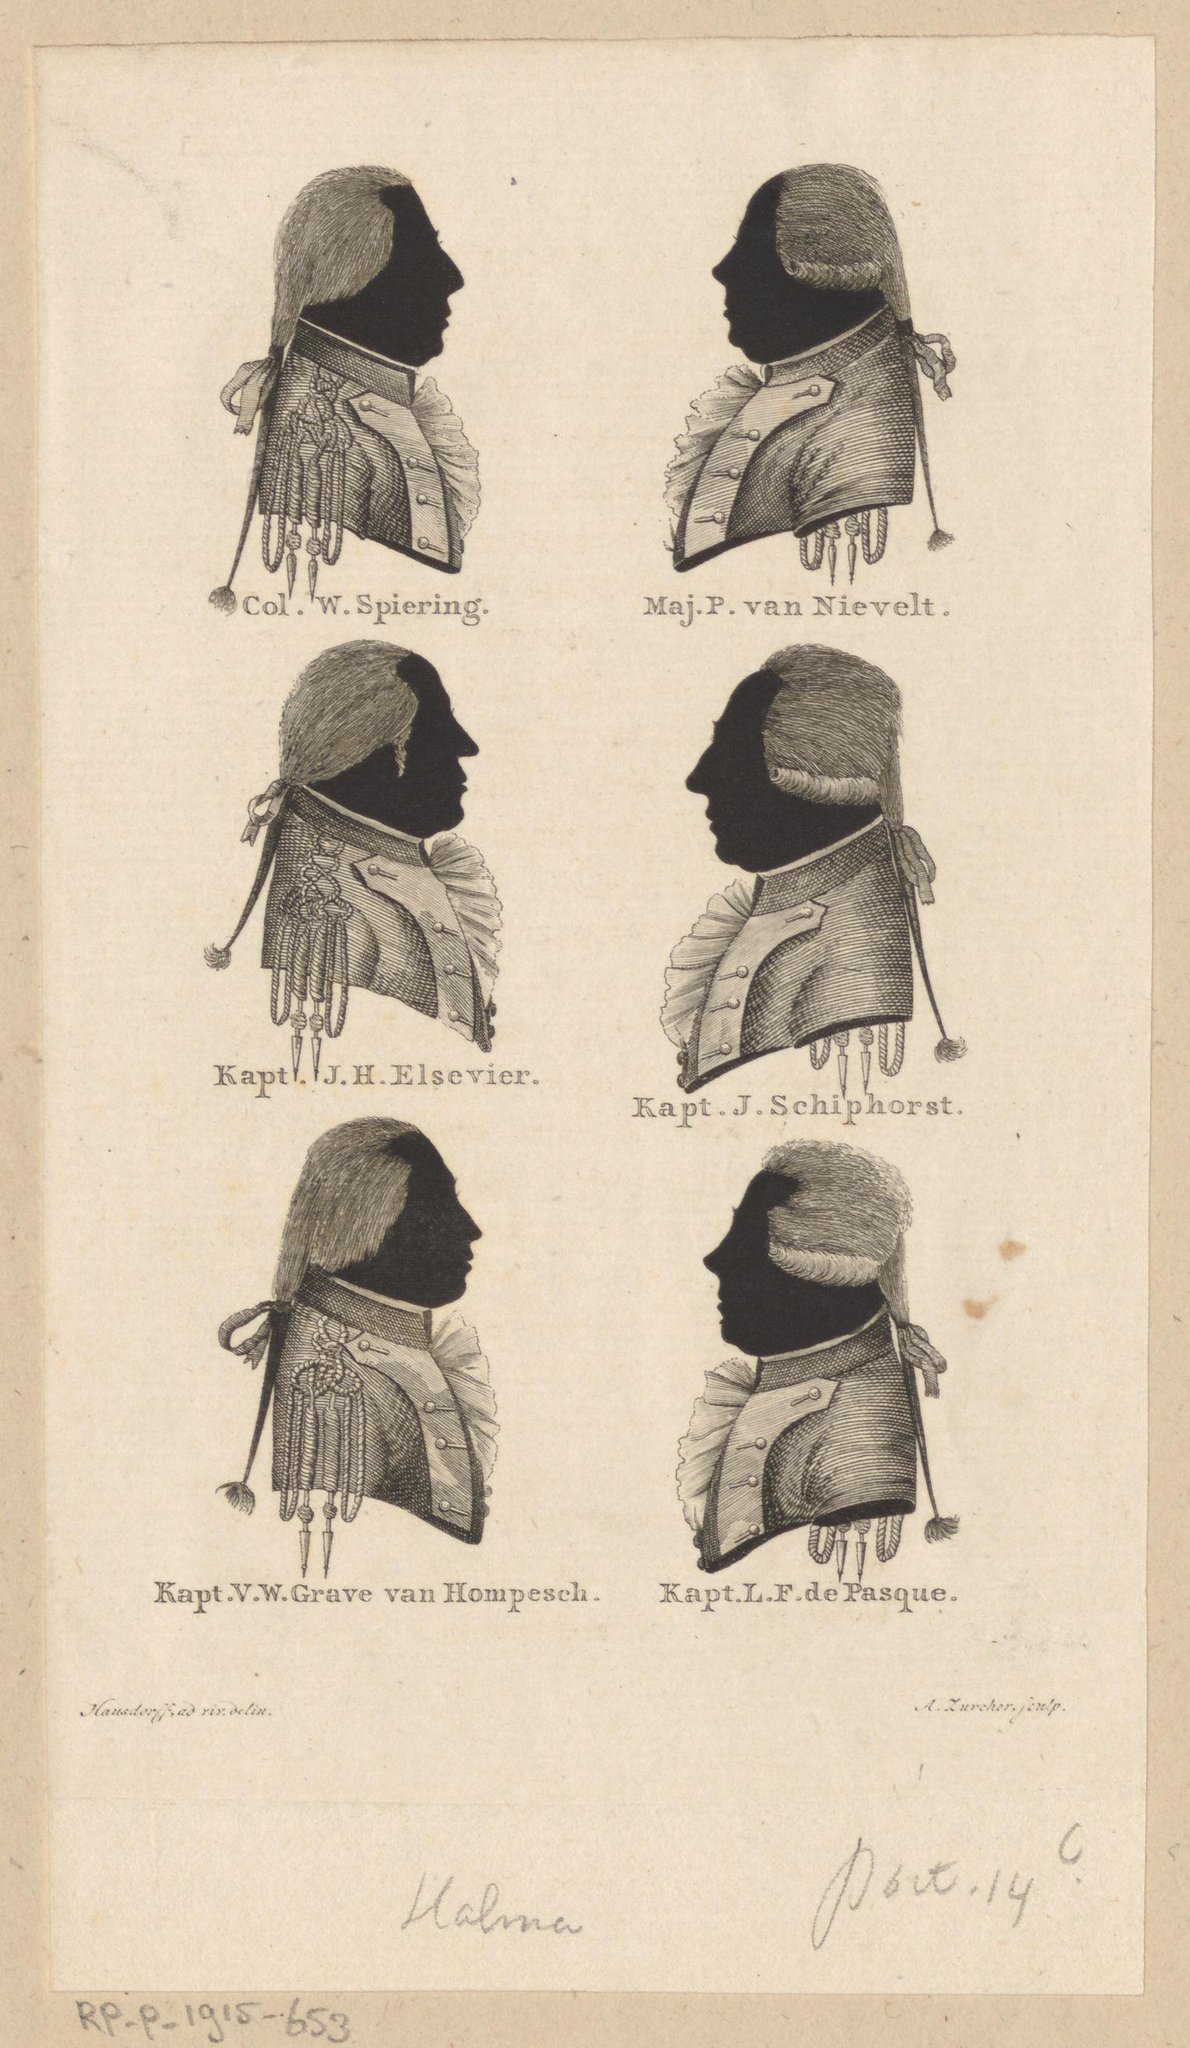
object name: print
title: Silhouetportretten van zes militairen betrokken bij de verdediging van Willemstad in 1793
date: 1793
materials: paper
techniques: engraving, etching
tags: historical persons, battle, fighting in general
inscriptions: collector's mark: Lugt 2228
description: Prent mogelijk uit: Oldenborgh, Pieter van. De belegering en verdediging van de Willemstad, in maart MDCCXCIII. Amsterdam: Johannes Allart, Dordrecht: Abraham en Pieter Blussé, 1793.